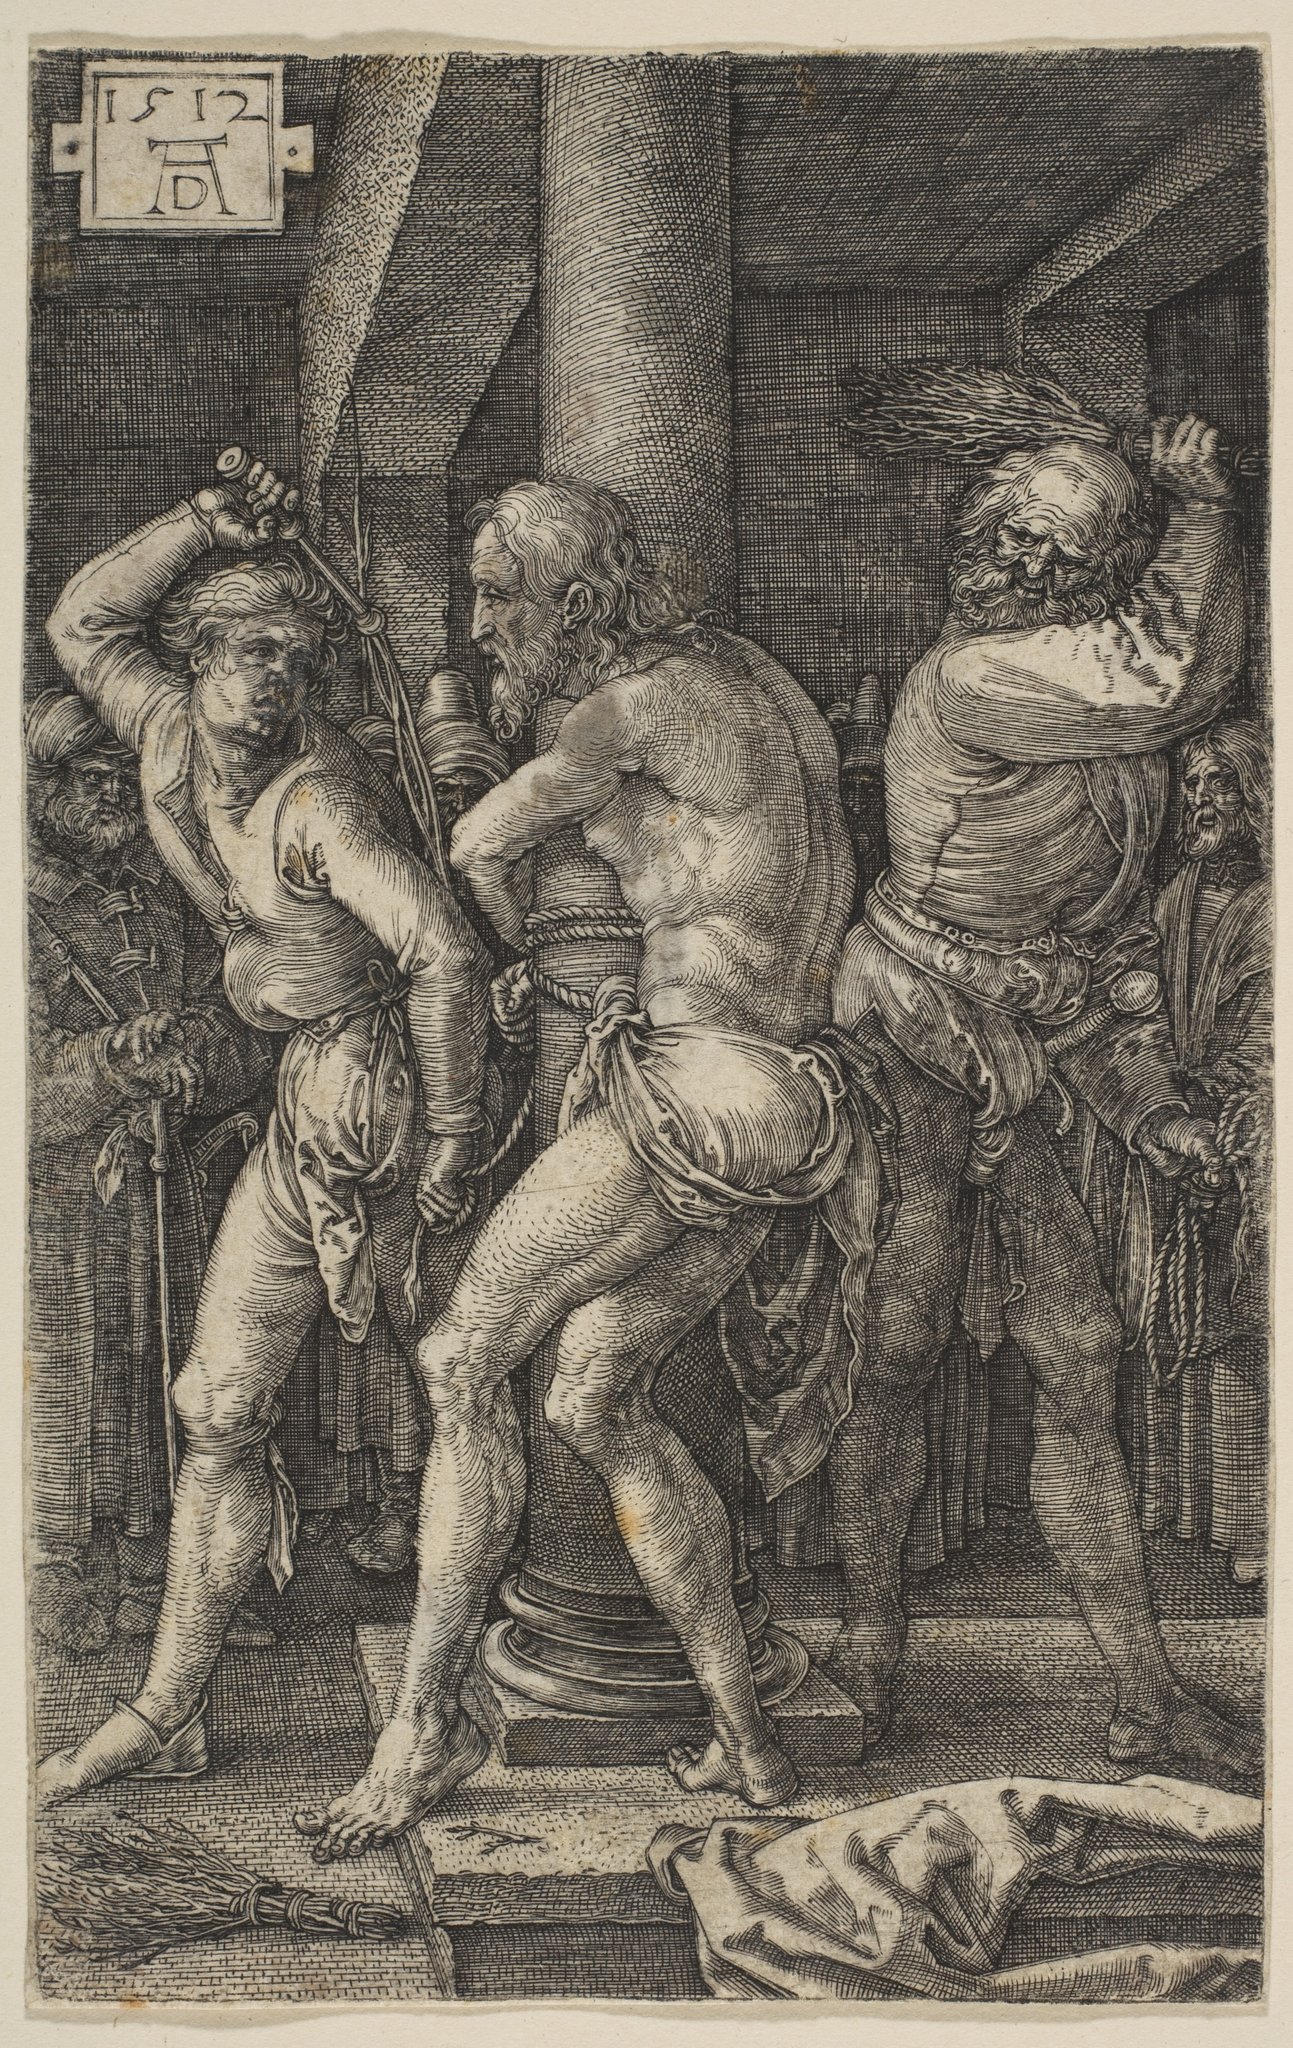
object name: print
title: The Flagellation, from "The Passion"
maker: albrecht dürer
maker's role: artist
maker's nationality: german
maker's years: 1471-1528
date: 1512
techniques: engraving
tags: men,jesus